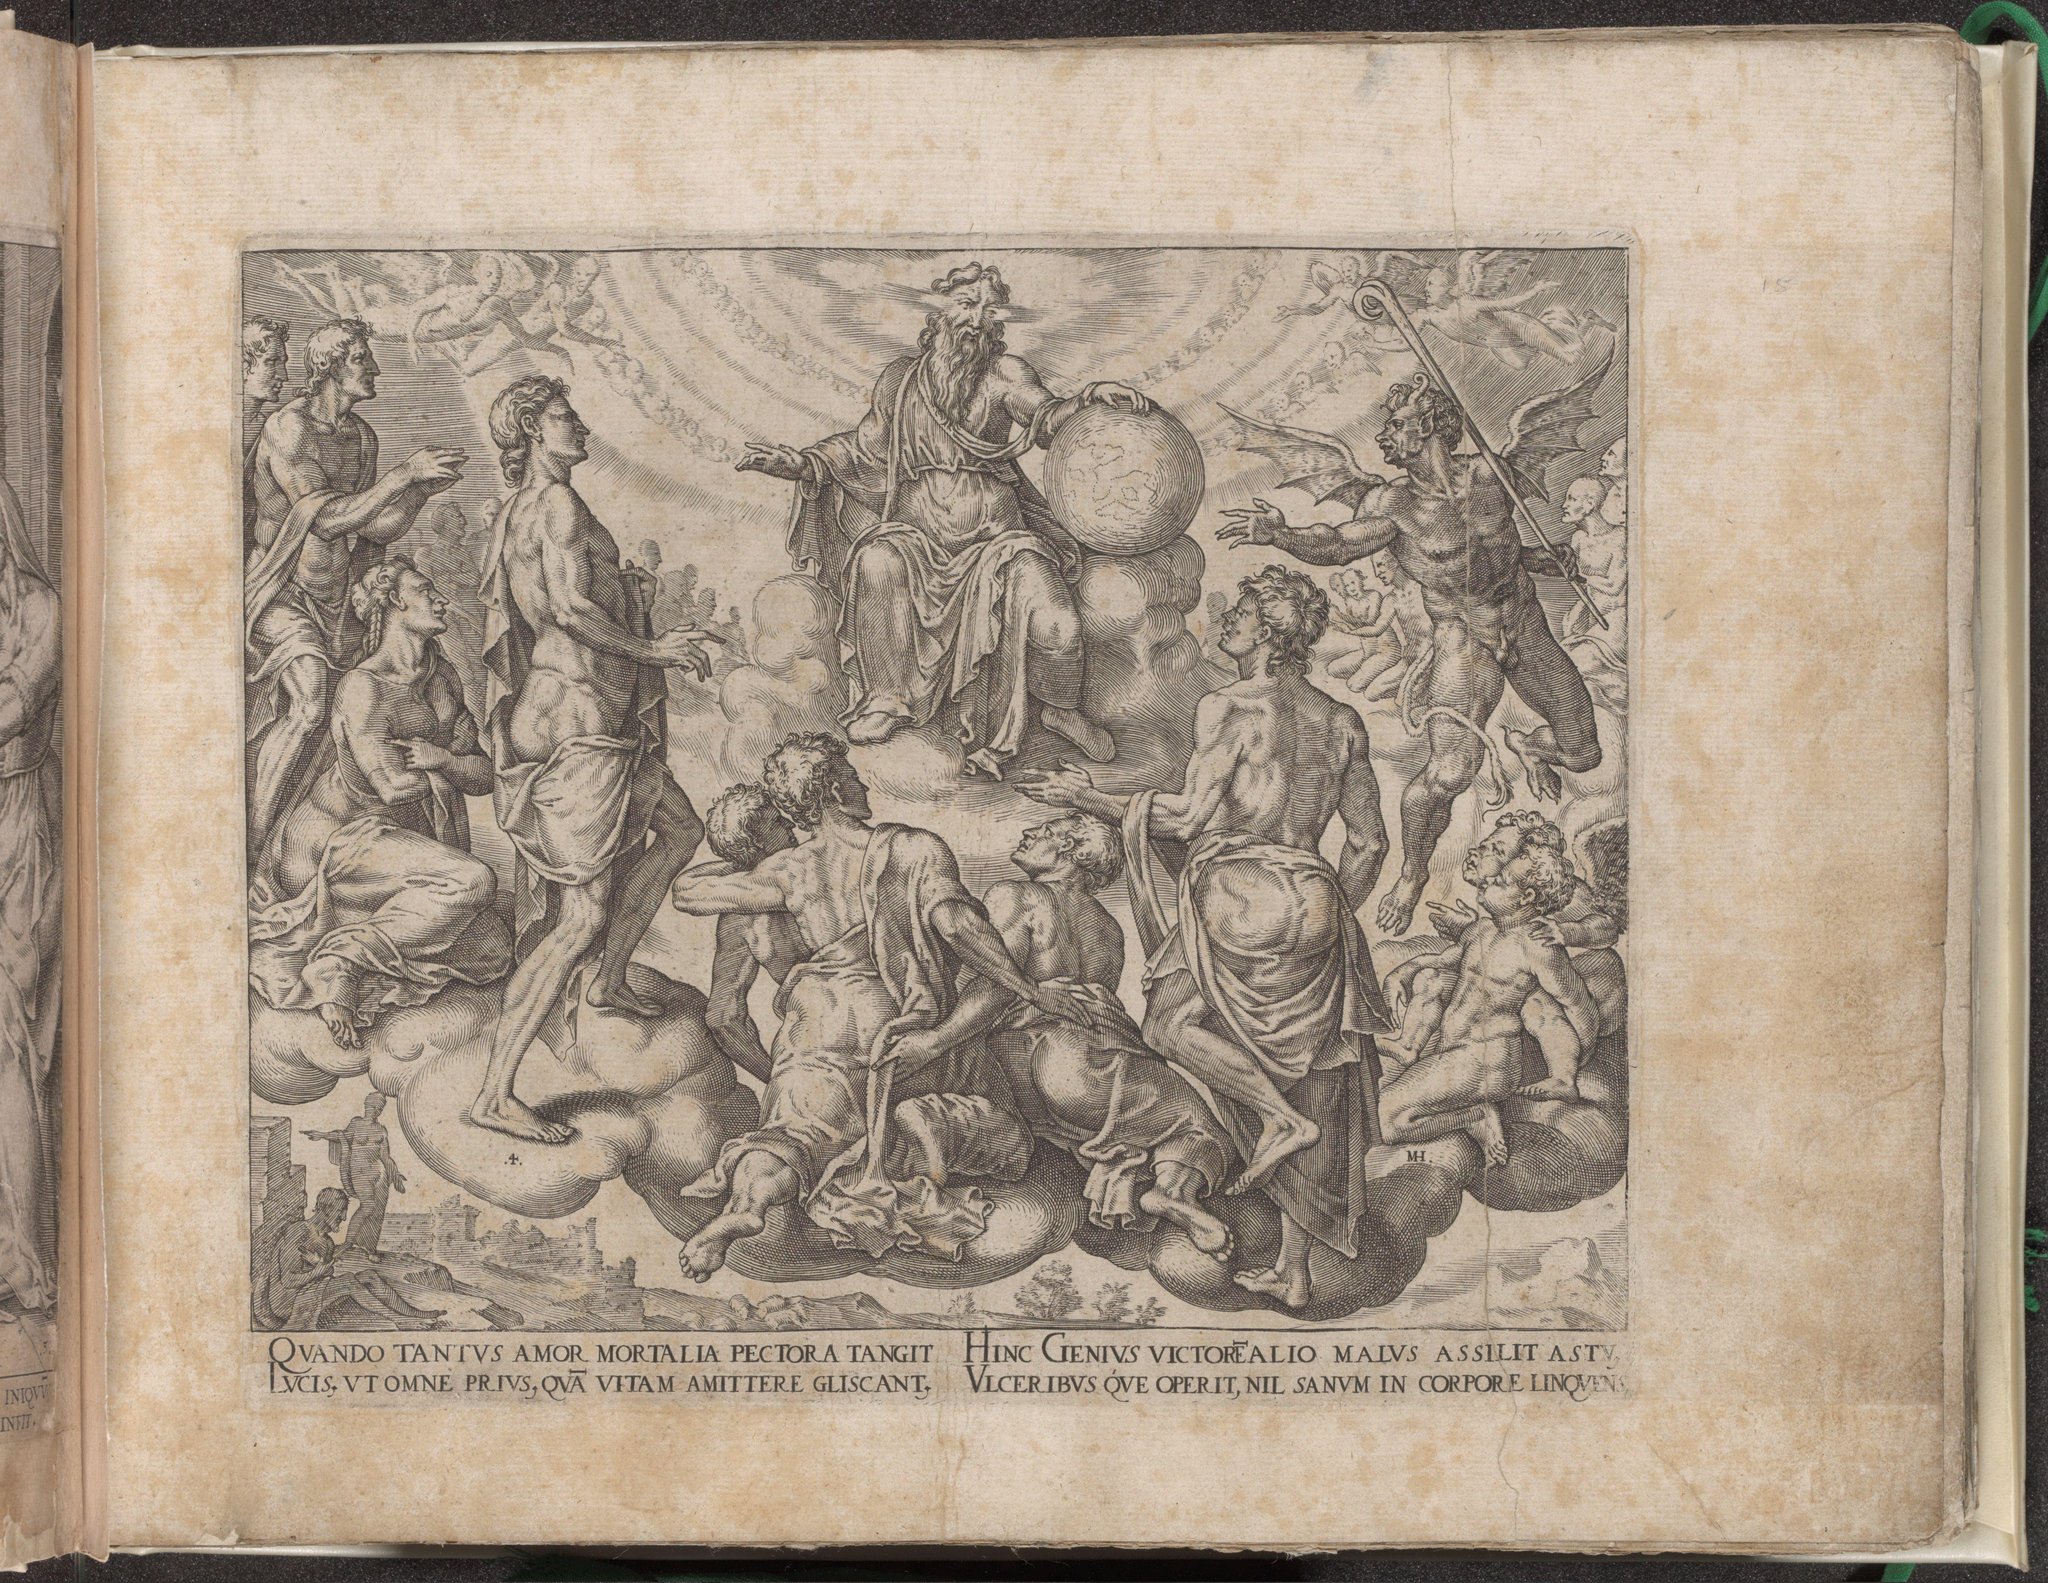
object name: album leaf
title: Geschiedenis van Job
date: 1563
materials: paper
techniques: engraving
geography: haarlem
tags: the 'sons of god' with satan gather again before god (job 2:1-6), god gives satan permission to test job's virtue further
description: God troont op een wolk met een globe naast zich. Om hem heen staan en zitten de overige hemelbewoners. Rechts Satan met vleugels en een dierenstaart. Satan daagt God uit om Job te beproeven. Onder de voorstelling een verklarende tekst in het Latijn. Deze prent maakt deel uit van een album.